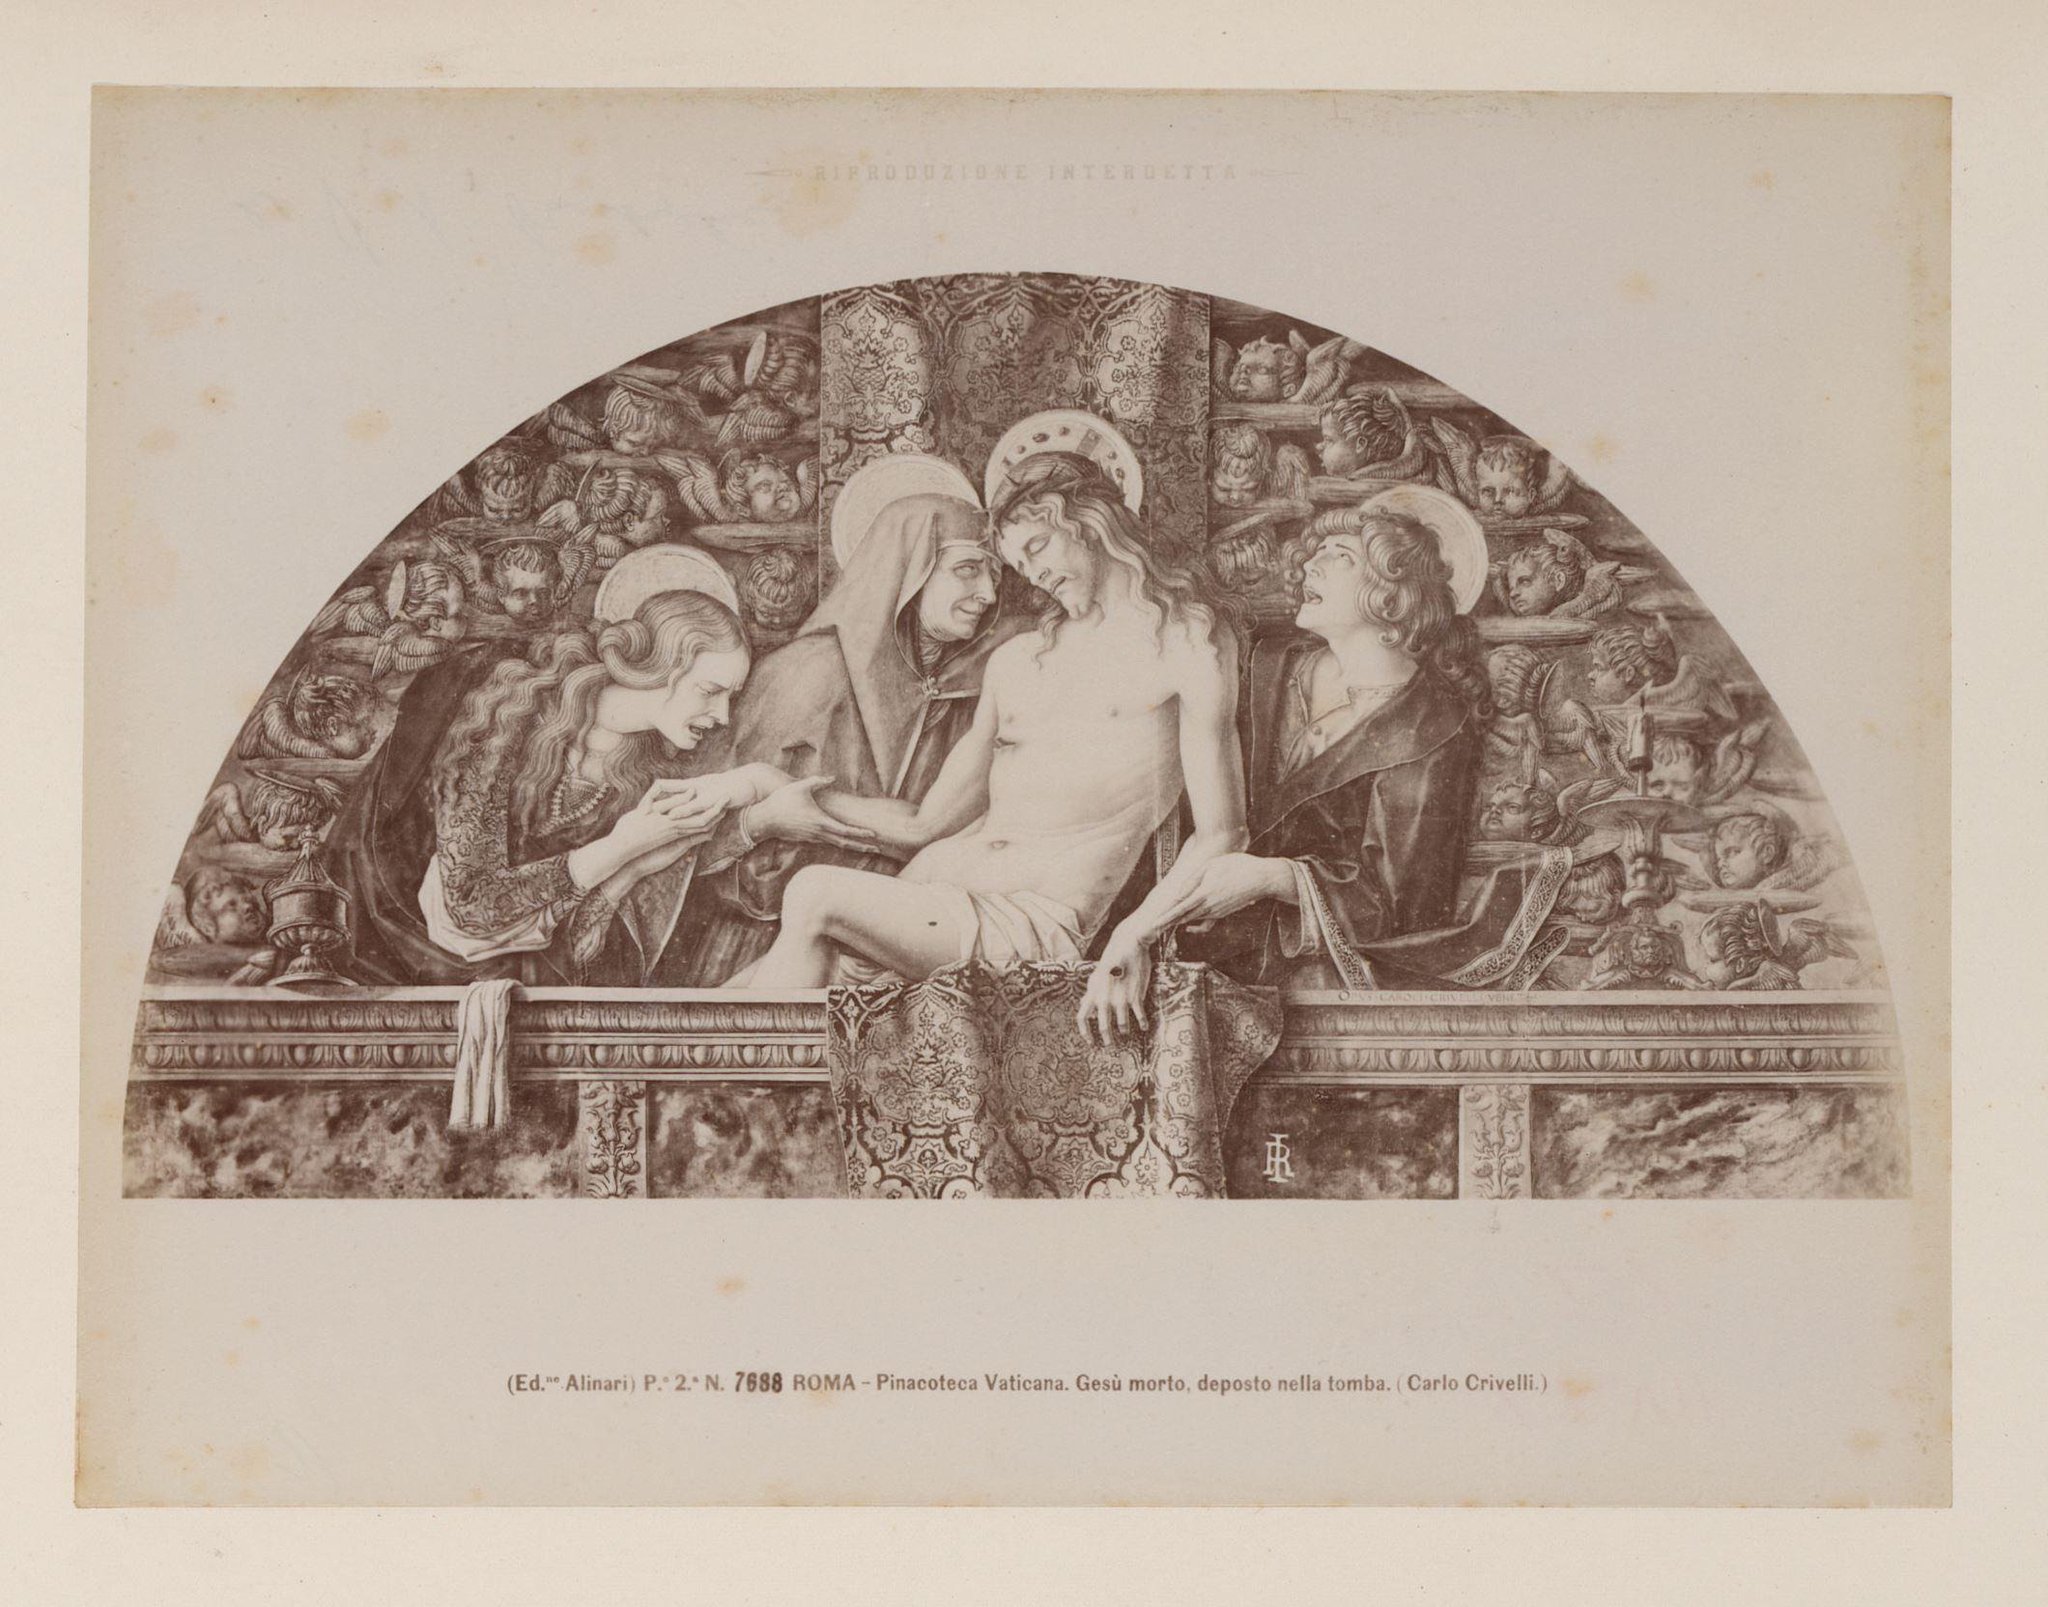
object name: reproduction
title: Gesù morto, deposto nella tomba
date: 1860-1900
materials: paper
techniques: albumen print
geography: florence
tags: christ is laid down ~ descent from the cross, picture, painting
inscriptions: monogram: ‘IR’, inscription: ‘Riproduzione Interdetta’, inscription: ‘(Ed.ne Alinari) P.e 2.a N. 7688 ROMA - Pinacoteca Vaticana. Gesù morto, deposito nella tomba. (Carlo Crivelli.)’